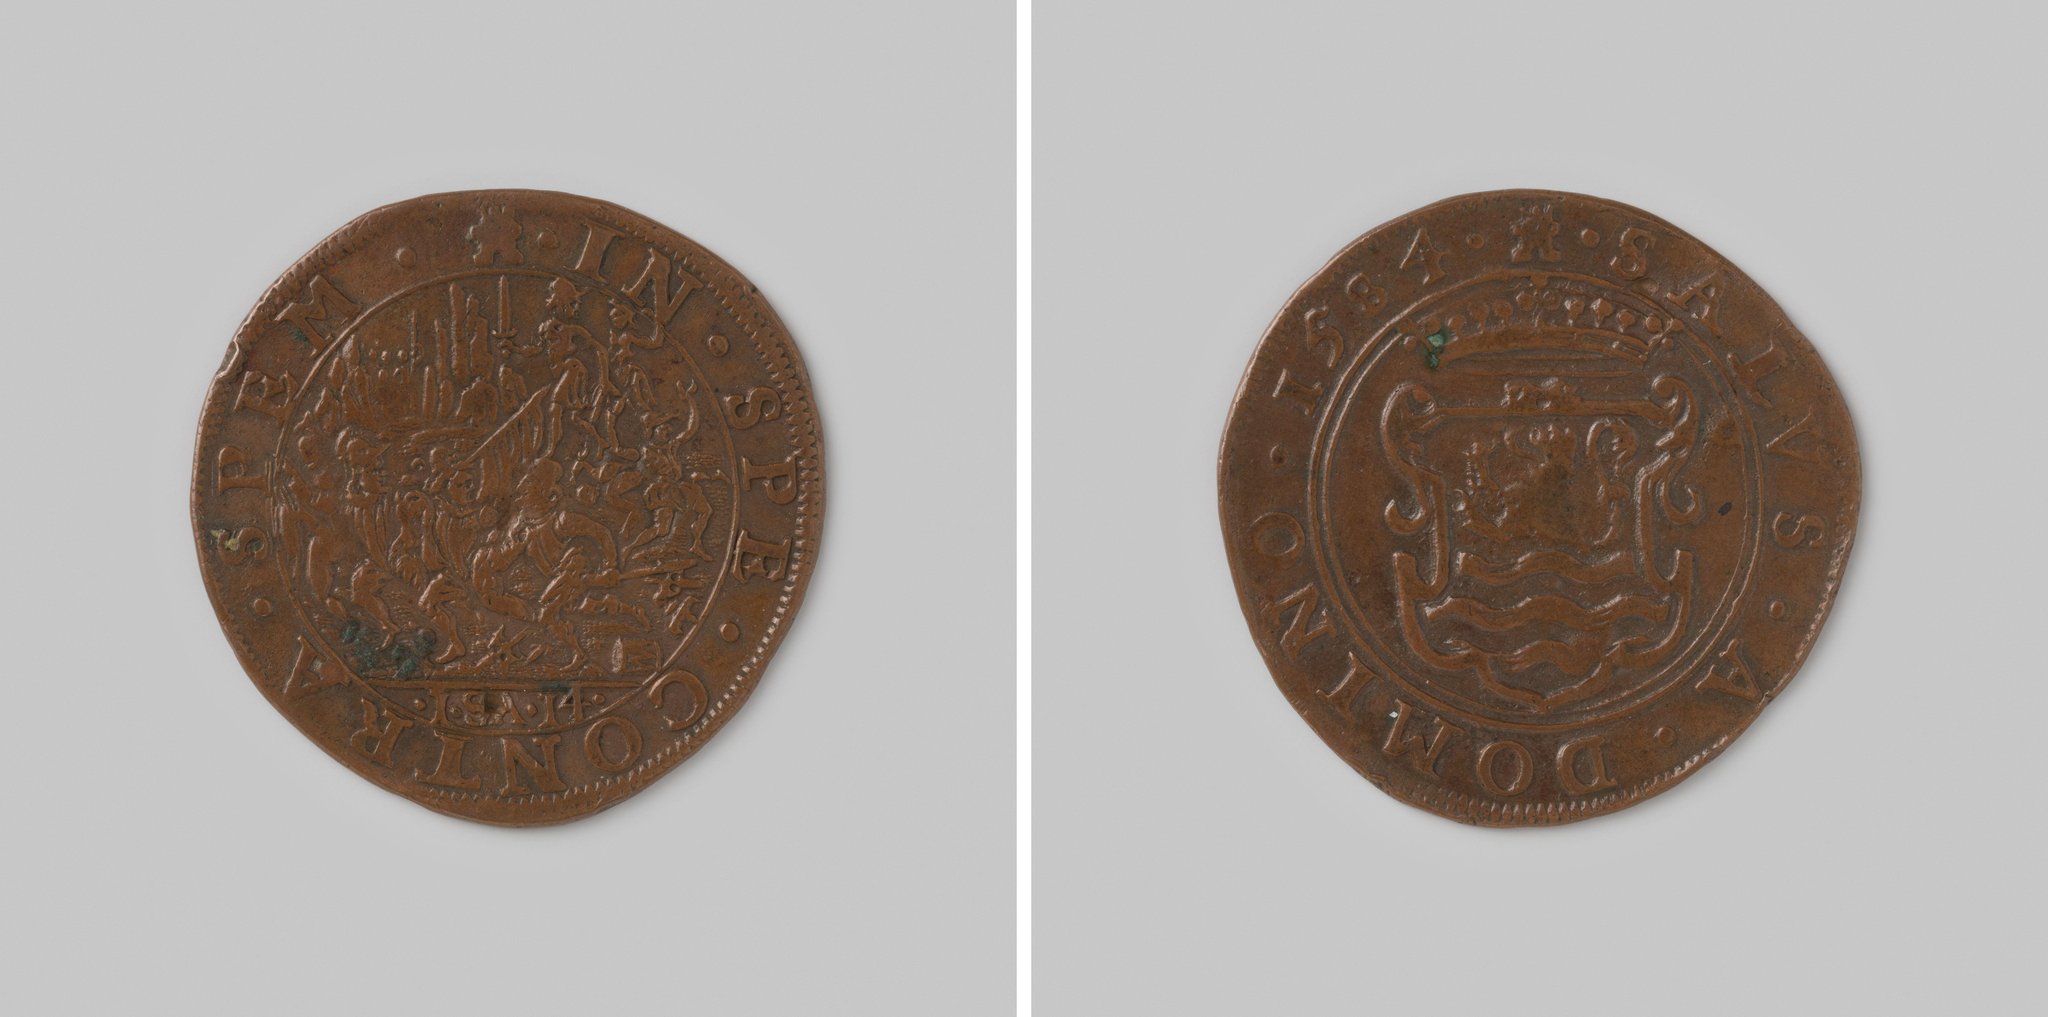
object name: jeton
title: Rekenpenning uit Middelburg op het moedig gedrag van de Staten 1584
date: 1584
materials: copper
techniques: striking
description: Koperen penning, op de voorzijde Jonathan die het leger der Filistijnen verdrijft, met omschrift en afsnedetekst, op de keerzijde het gekroonde wapenschild van Zeeland met omschrift.